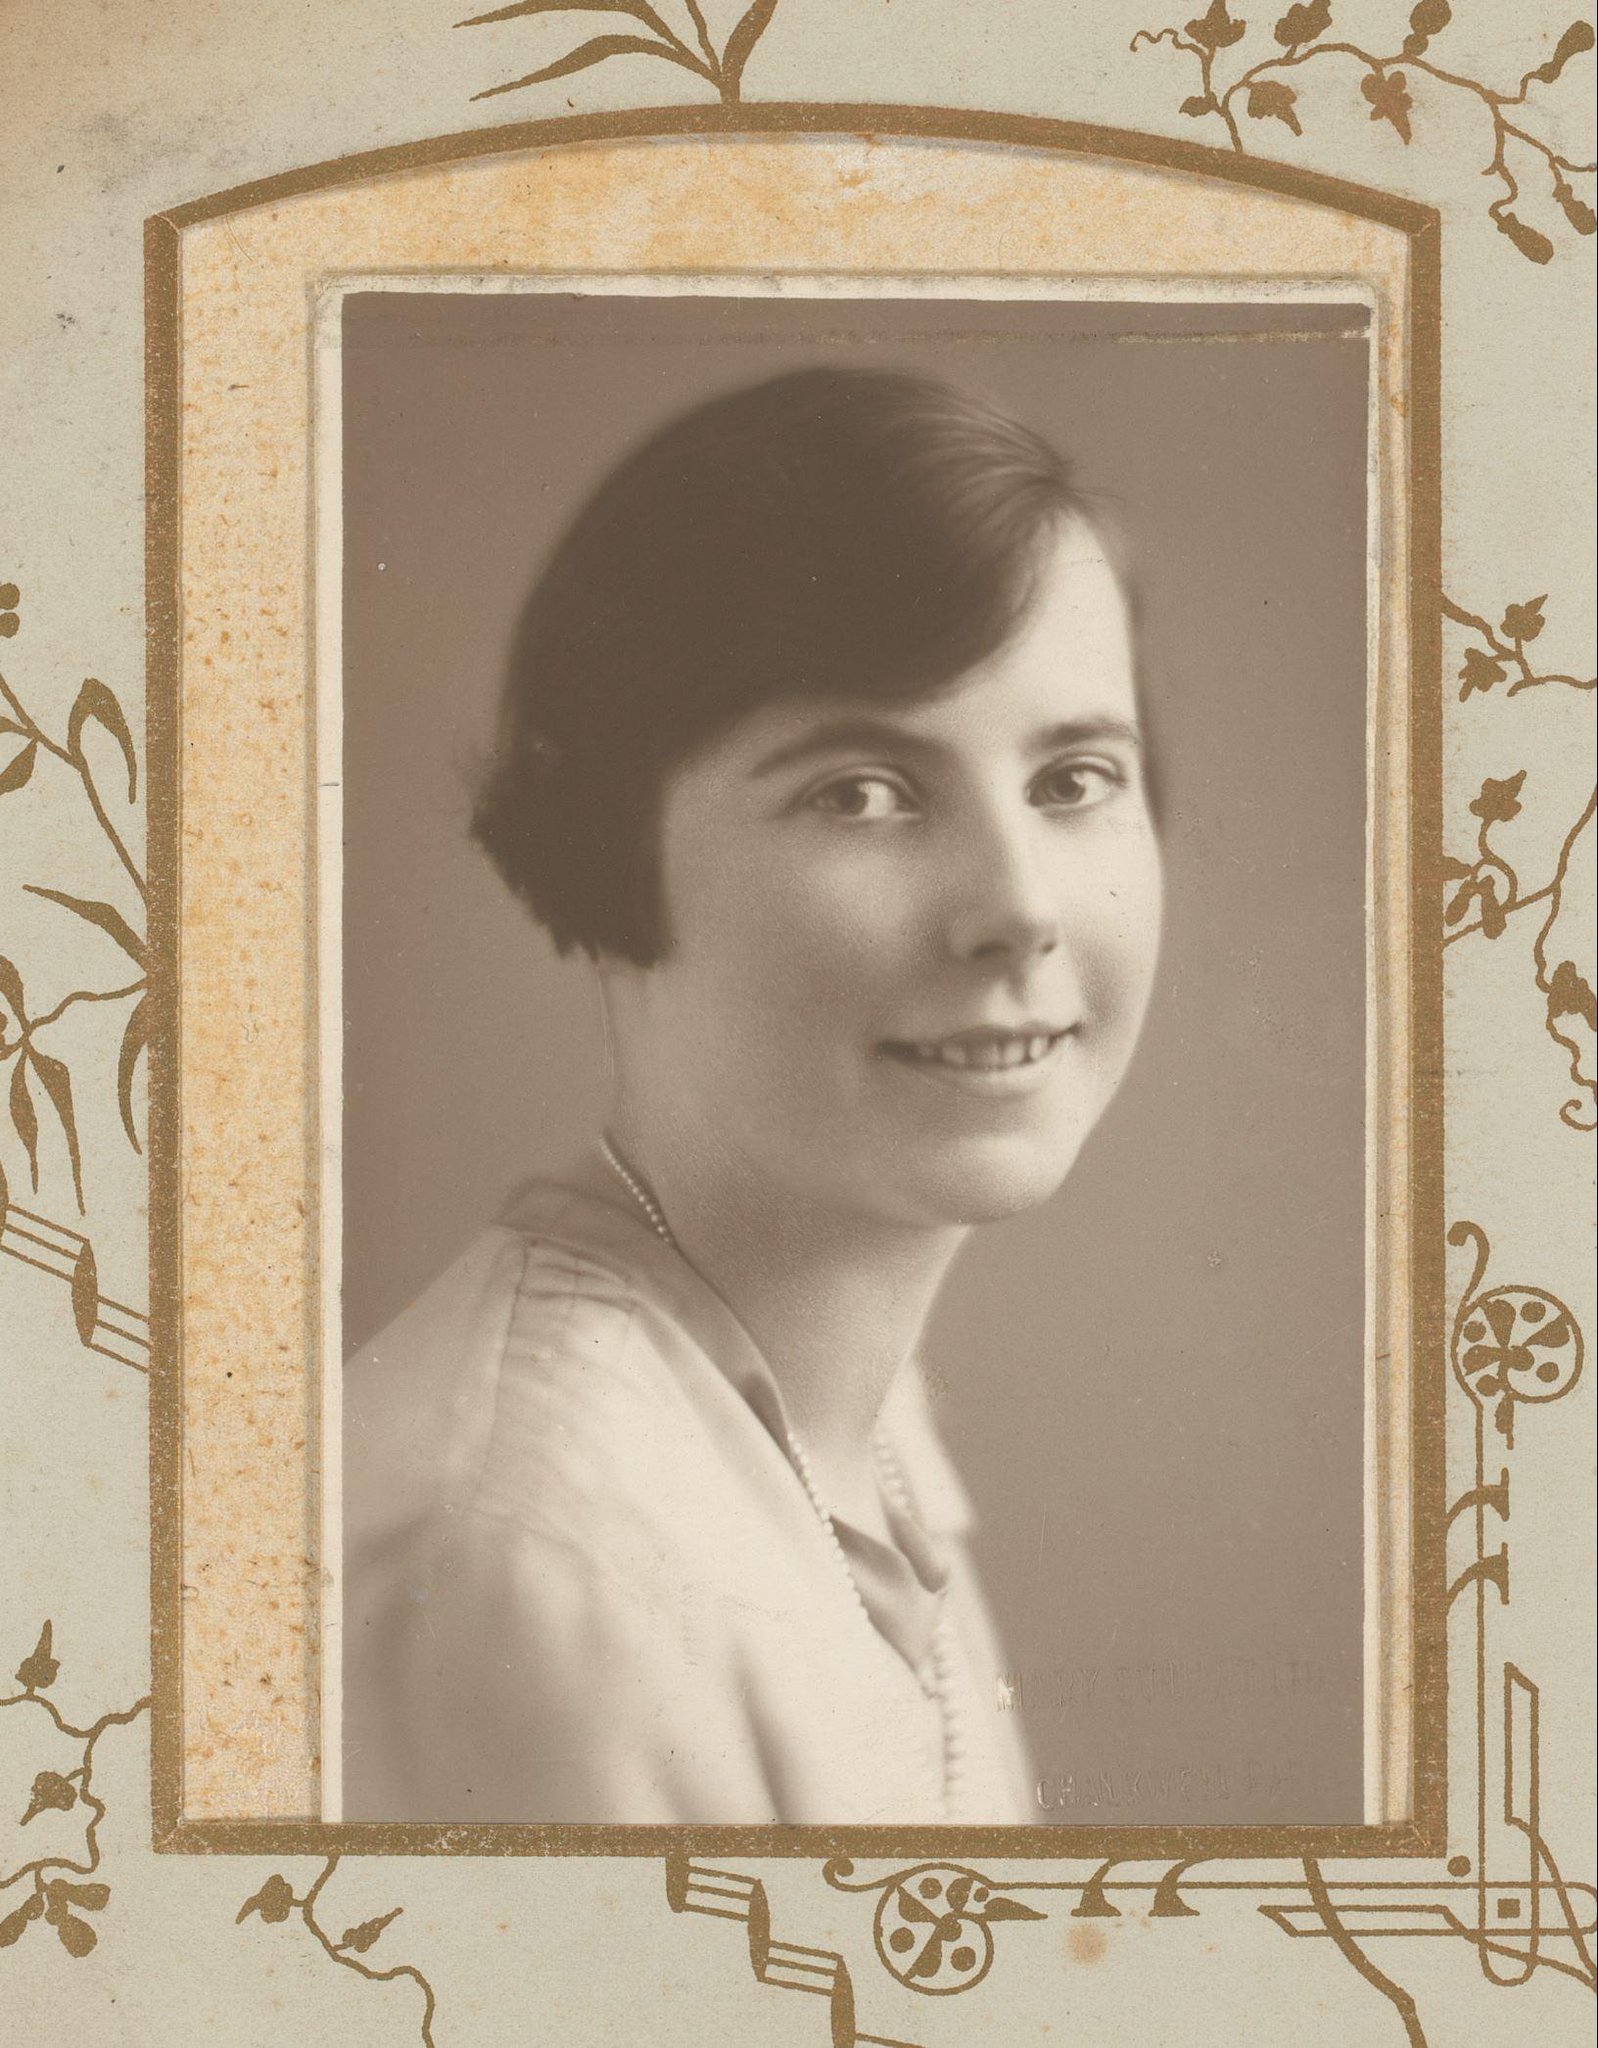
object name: album leaf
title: Portret van een jonge vrouw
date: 1899-1940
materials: photographic support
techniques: gelatin silver print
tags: adolescent, young woman, maiden, historical persons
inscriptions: workshop stamp: ‘Mary Stuart LTD/ Chalkwell Park’